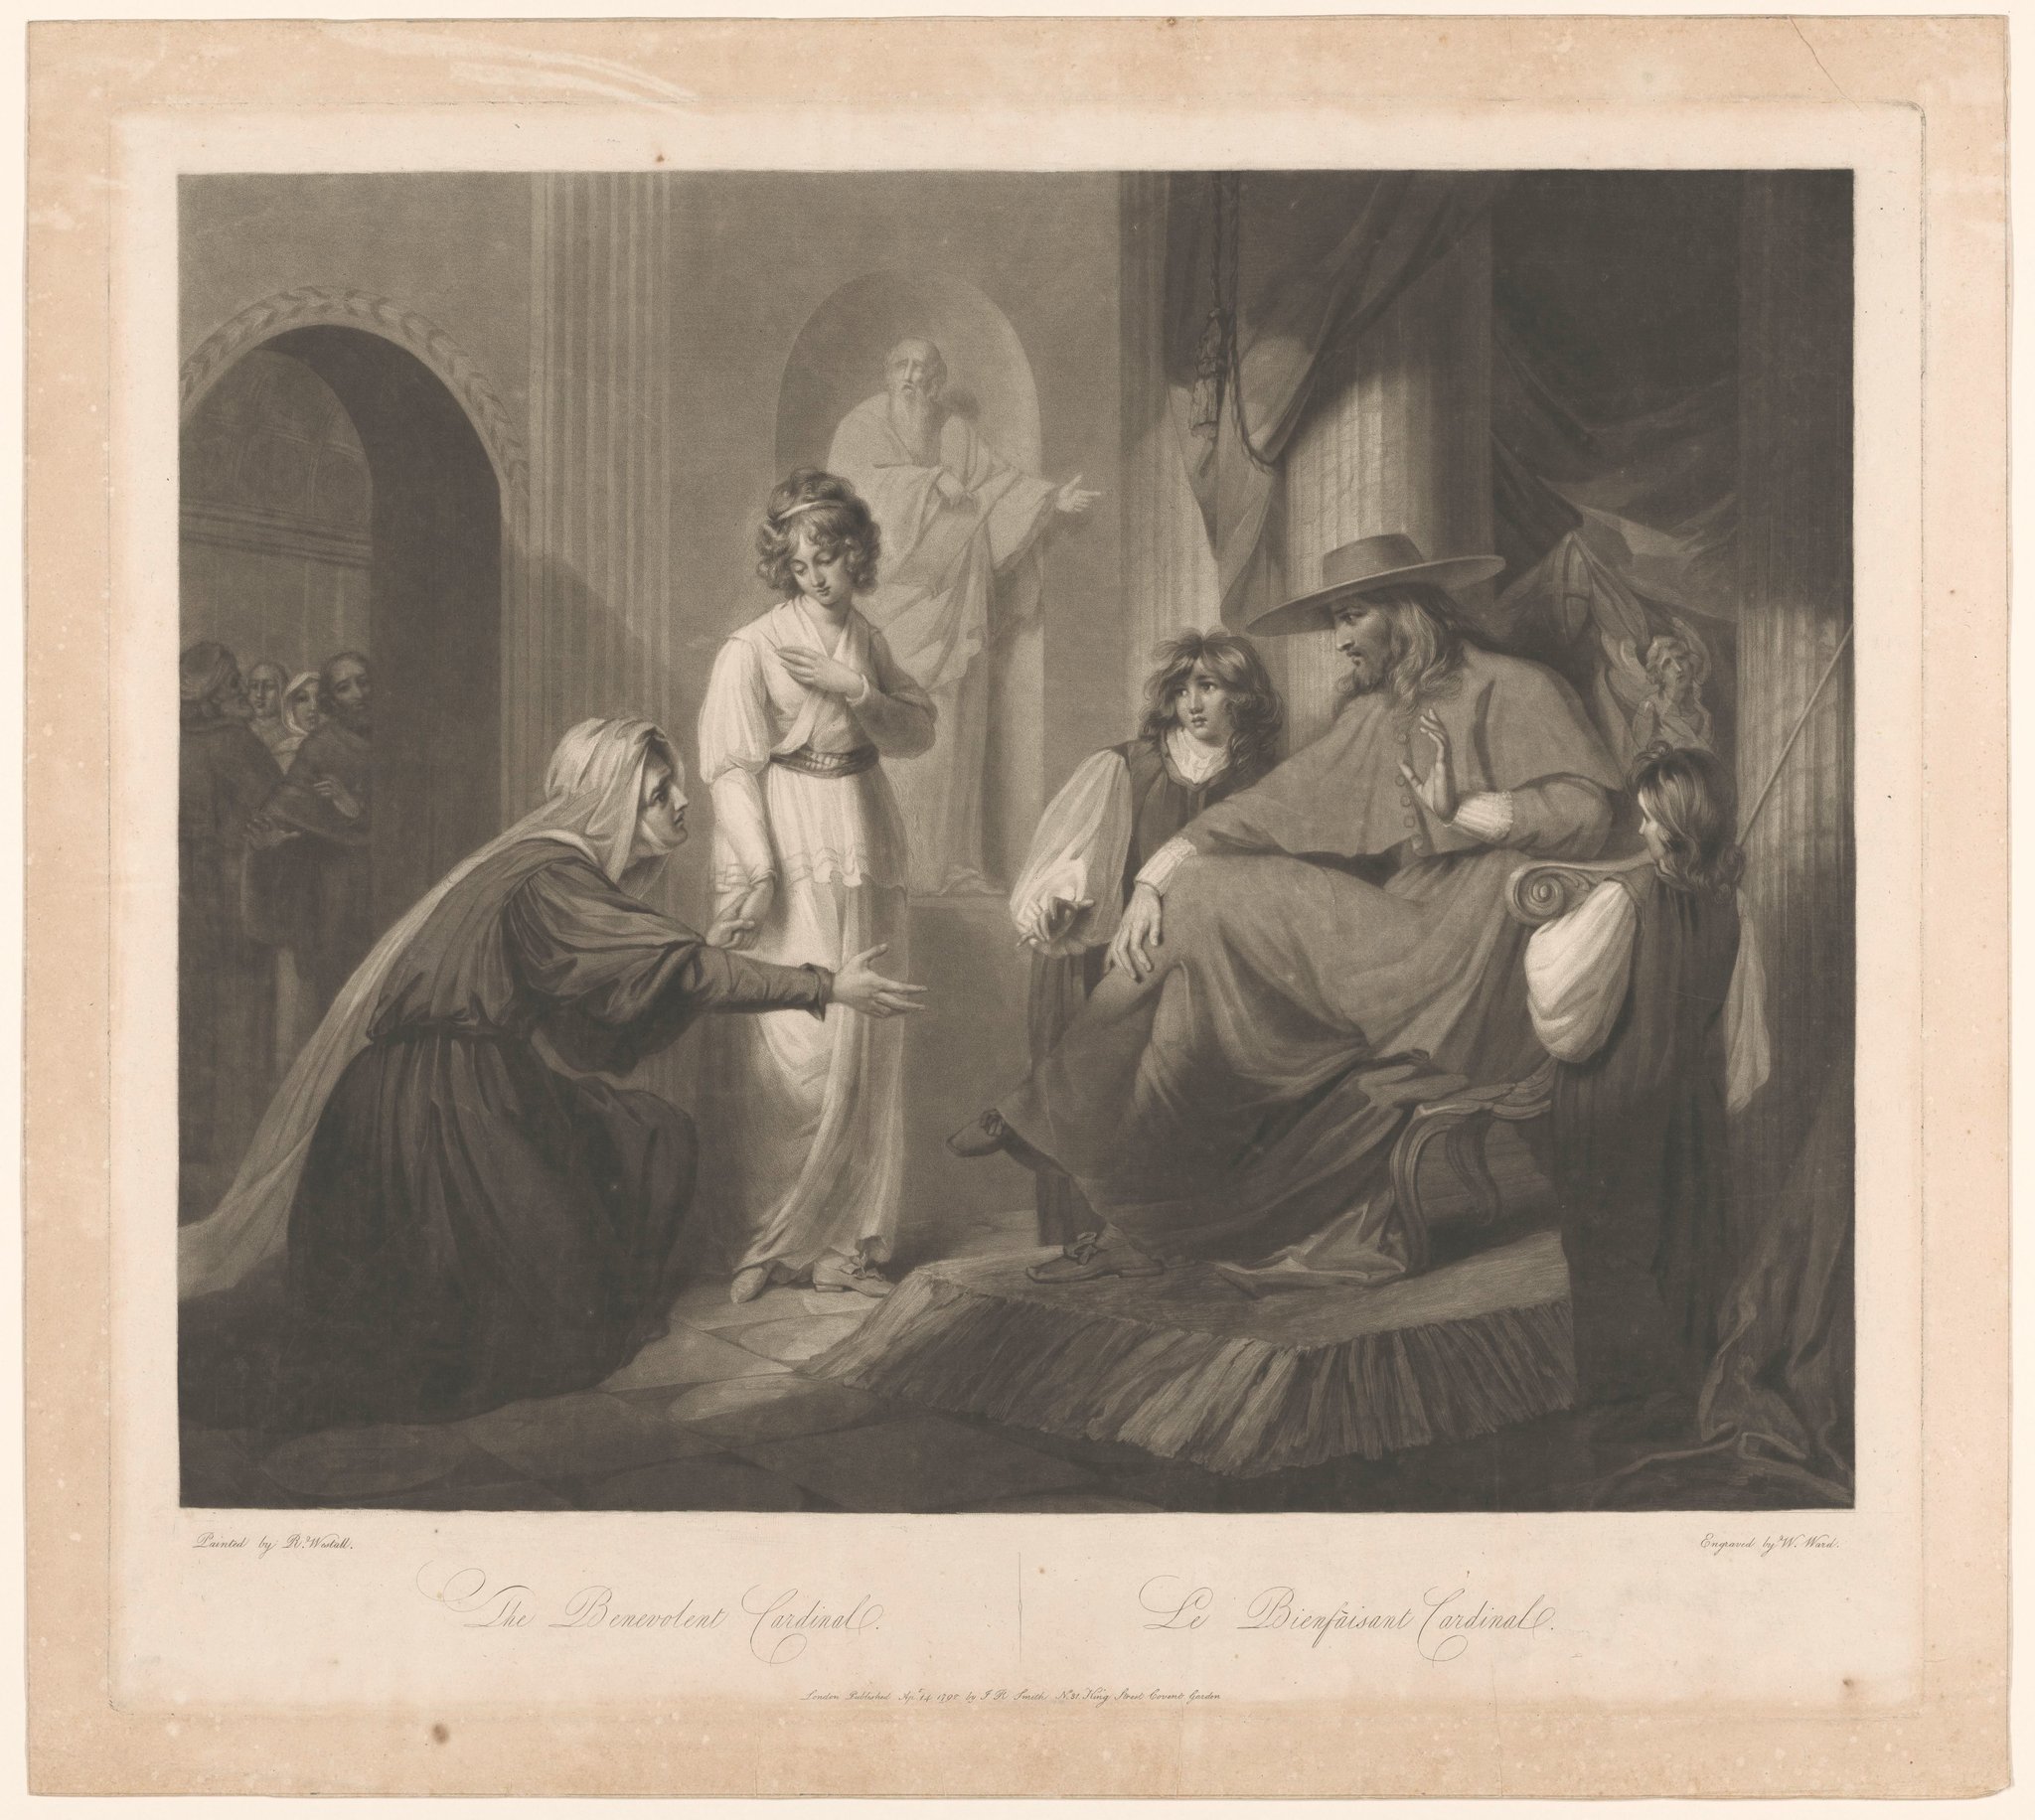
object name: print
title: Audiëntie bij een kardinaal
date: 1792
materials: paper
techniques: mezzotint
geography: england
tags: cardinal, kneeling on both knees - aa - female human figure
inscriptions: collector's mark: Lugt 2233